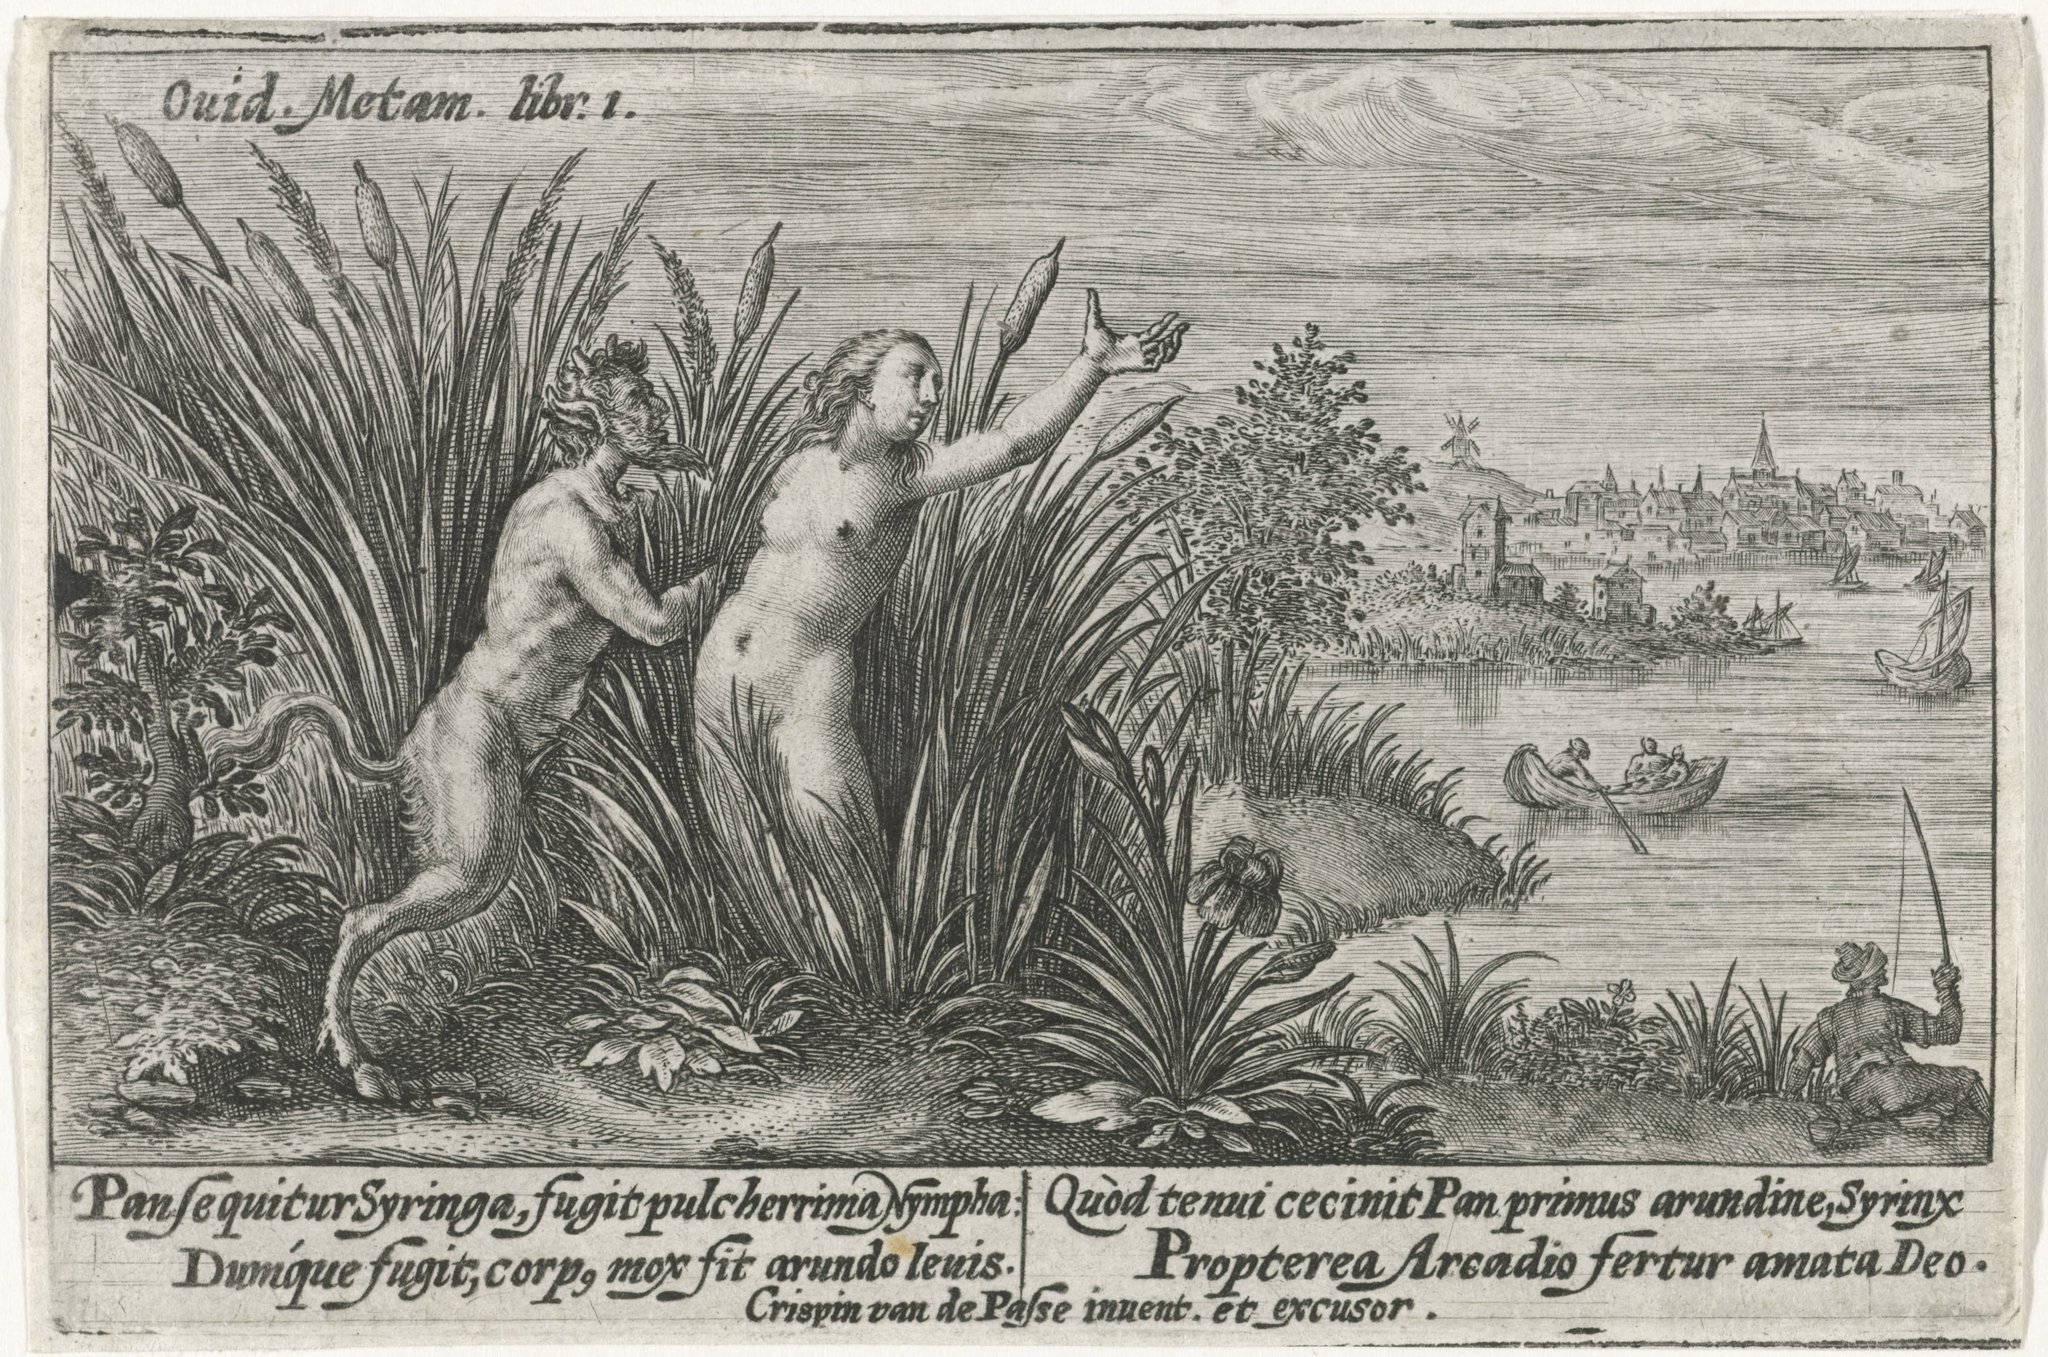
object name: print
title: Metamorfosen van Ovidius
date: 1602-1607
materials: paper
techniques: engraving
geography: cologne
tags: syrinx changed into a reed: while fleeing from pan, the nymph syrinx is changed into reed by her sisters, the naiads (ovid, metamorphoses i 705)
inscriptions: collector's mark: Lugt 2228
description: Pan achtervolgt de nimf Syrinx. Zij bad om een gedaanteverwisseling om aan de god te ontkomen, haar zussen veranderen haar in riethalmen. Syrinx staat tussen het riet aan de oever van de rivier de Ladon. In de marge een vierregelig onderschrift, in twee kolommen, in het Latijn.